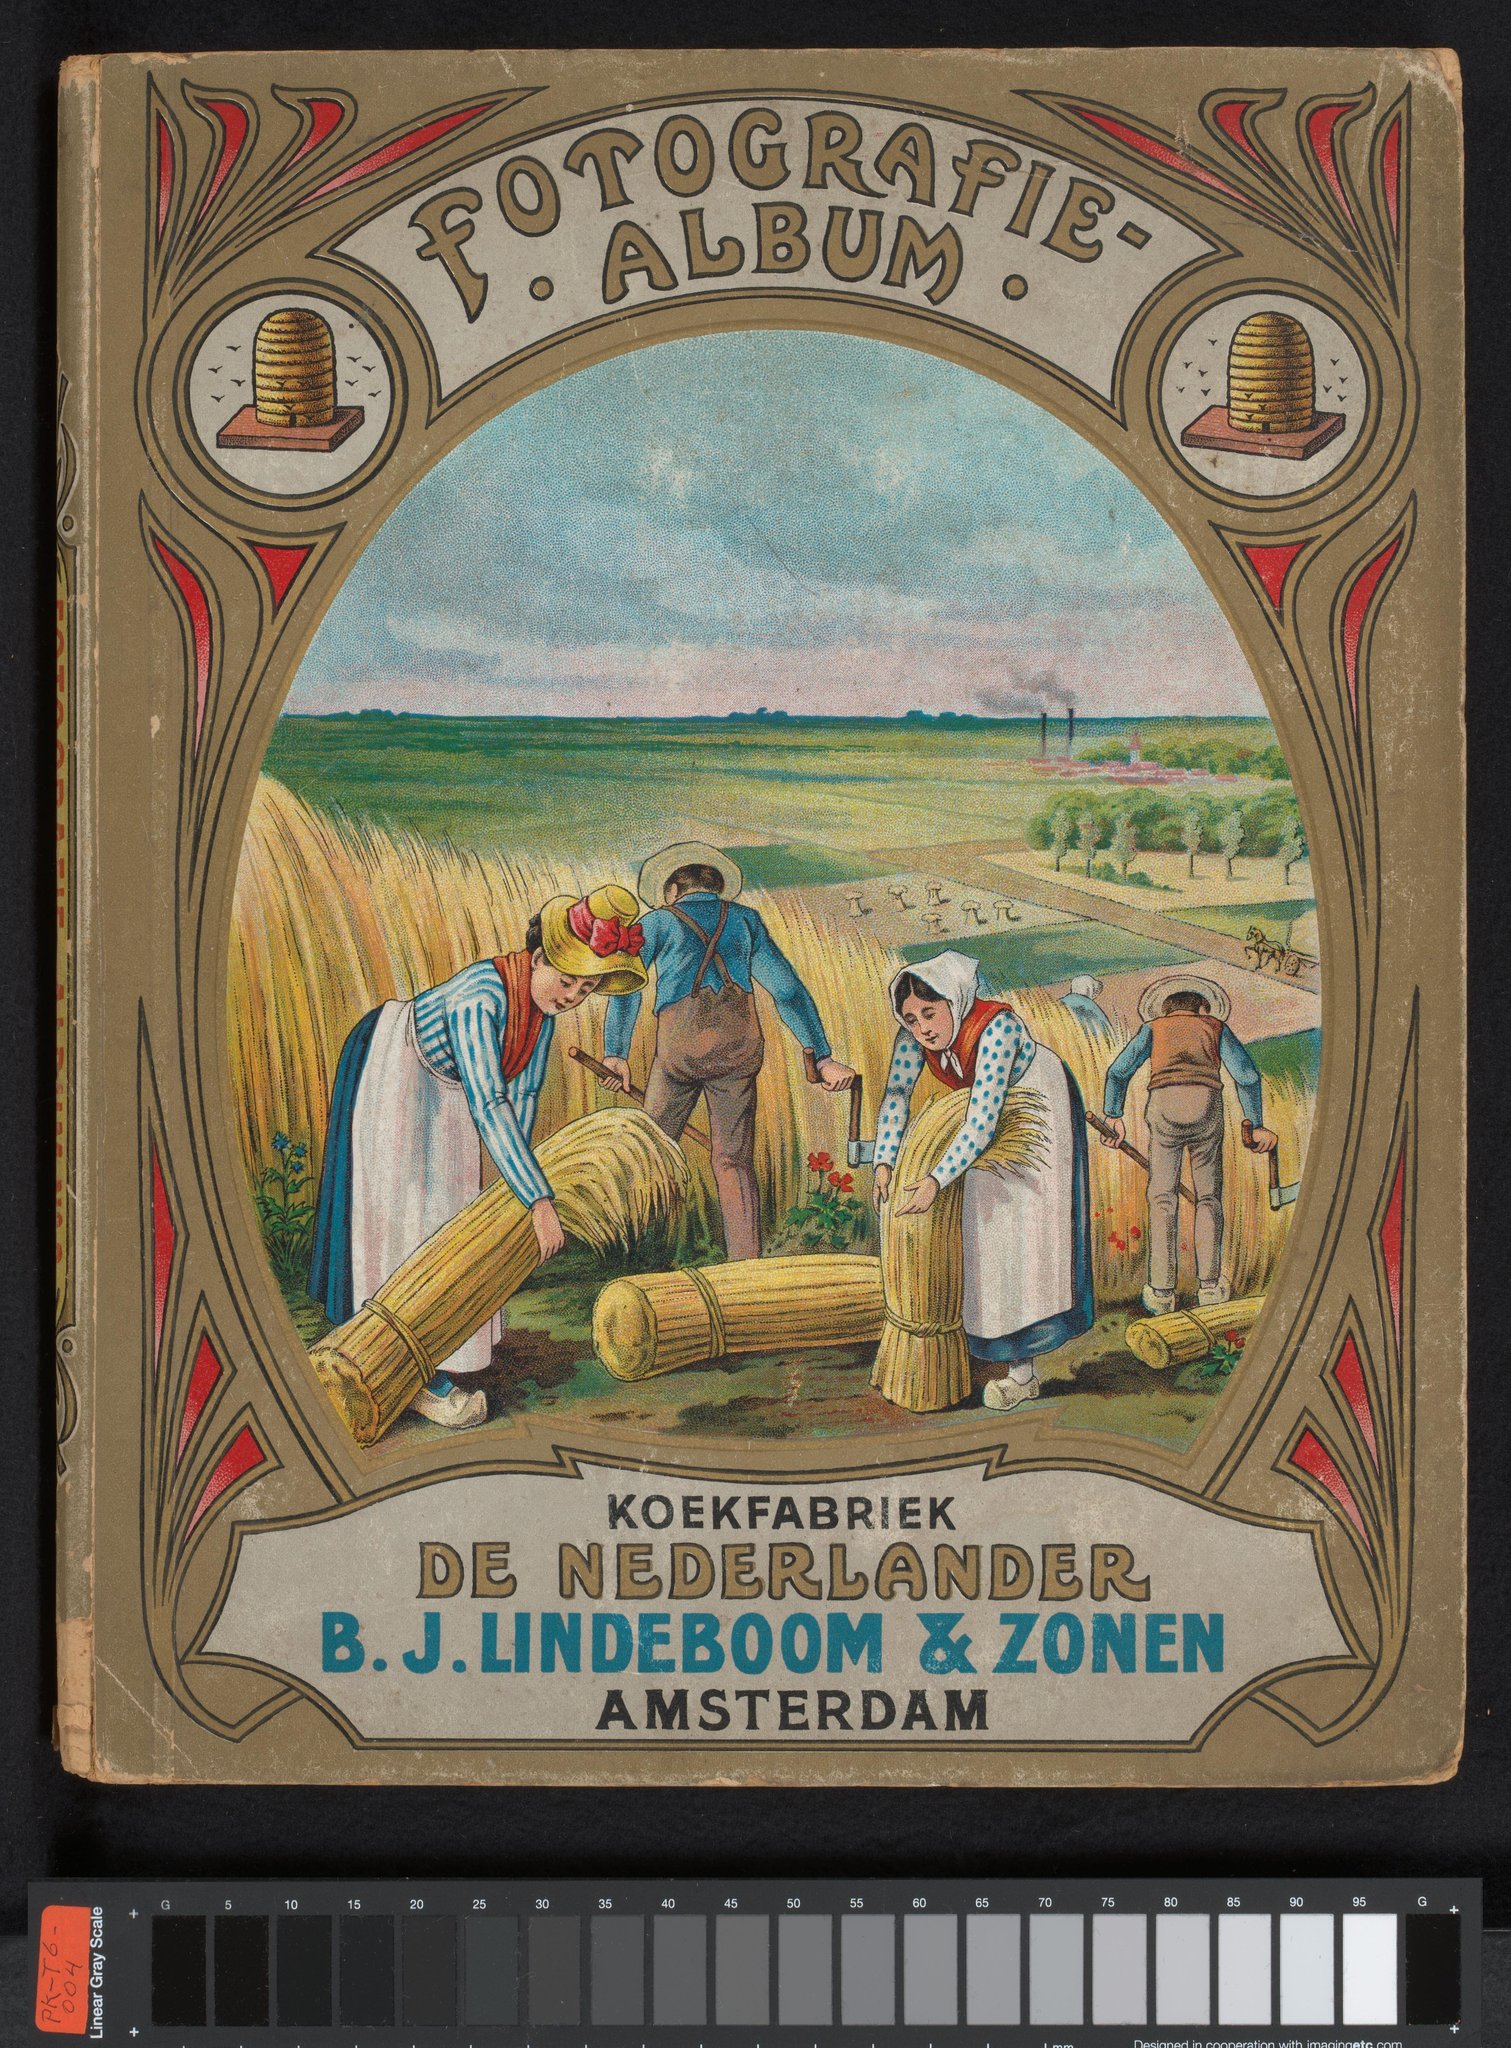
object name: photograph album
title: Fotografie/ Album/ koekfabriek/ De Nederlander/ B J Lindeboom & Zonen/ Amsterdam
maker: Anonymous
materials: cardboard, paper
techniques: photograph, printing, printing block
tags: wilhelmina of the netherlands, the hague, painter, print maker, draughtsman, hendrik willem mesdag, historical persons - bb - woman, historical persons, portrait of a writer, portrait of composer, monument, statue, portrait, self-portrait of artist, war, prospect of city, town panorama, silhouette of city, netherlands, italy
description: Fotoalbum met betrekking tot de koekfabriek De Nederlander van B.J. Lindeboom & Zonen in Amsterdam. Het album bevat 24 pagina's met ieder 6 passe-partouts. Niet alle passe-partouts zijn gevuld. In totaal bevat het album 141 prenten. De prenten zaten als verzamelpaatjes bij producten van de koekfabriek voor de jaargang 1905 - 1906. Verzamelaars konden een jaar lang prenten sparen voor elk album. De prenten zijn ingedeeld op thema's, die ieder 1 of 2 pagina's beslaan. Een aantal thema's in dit album zijn beroemde schrijvers, standbeelden, regerende vorsten en stadhuizen.